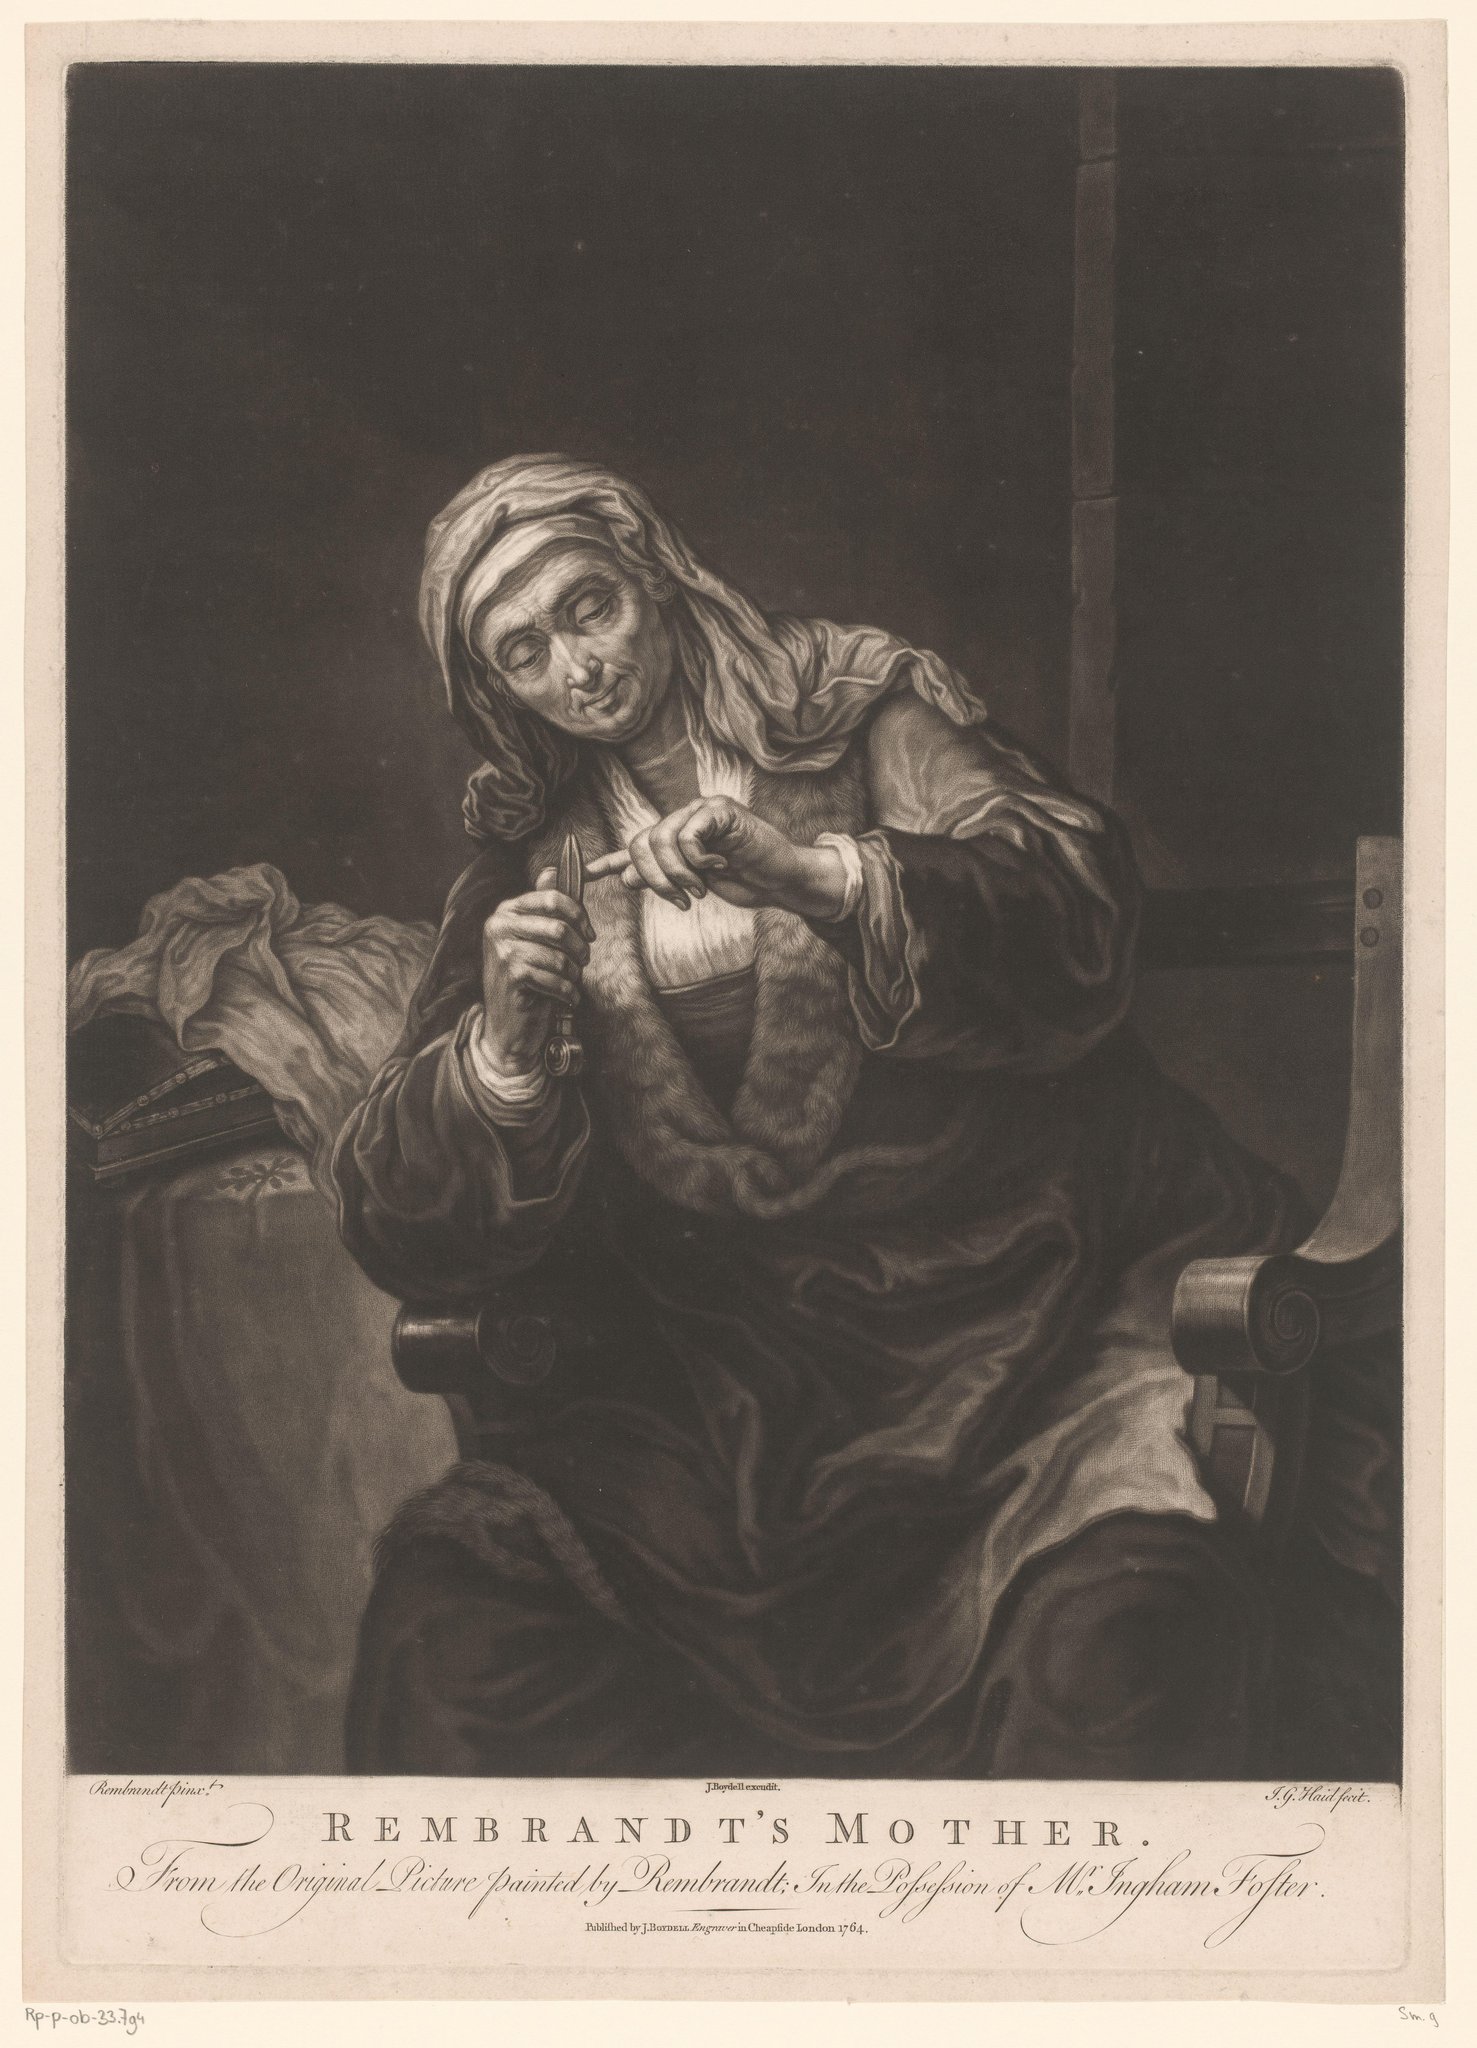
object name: print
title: Zittende oude vrouw knipt haar nagels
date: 1764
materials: paper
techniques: mezzotint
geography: château de villette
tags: old woman, nails (fingers), tools, aids, implements ~ crafts and industries: scissors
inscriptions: collector's mark: Lugt 240